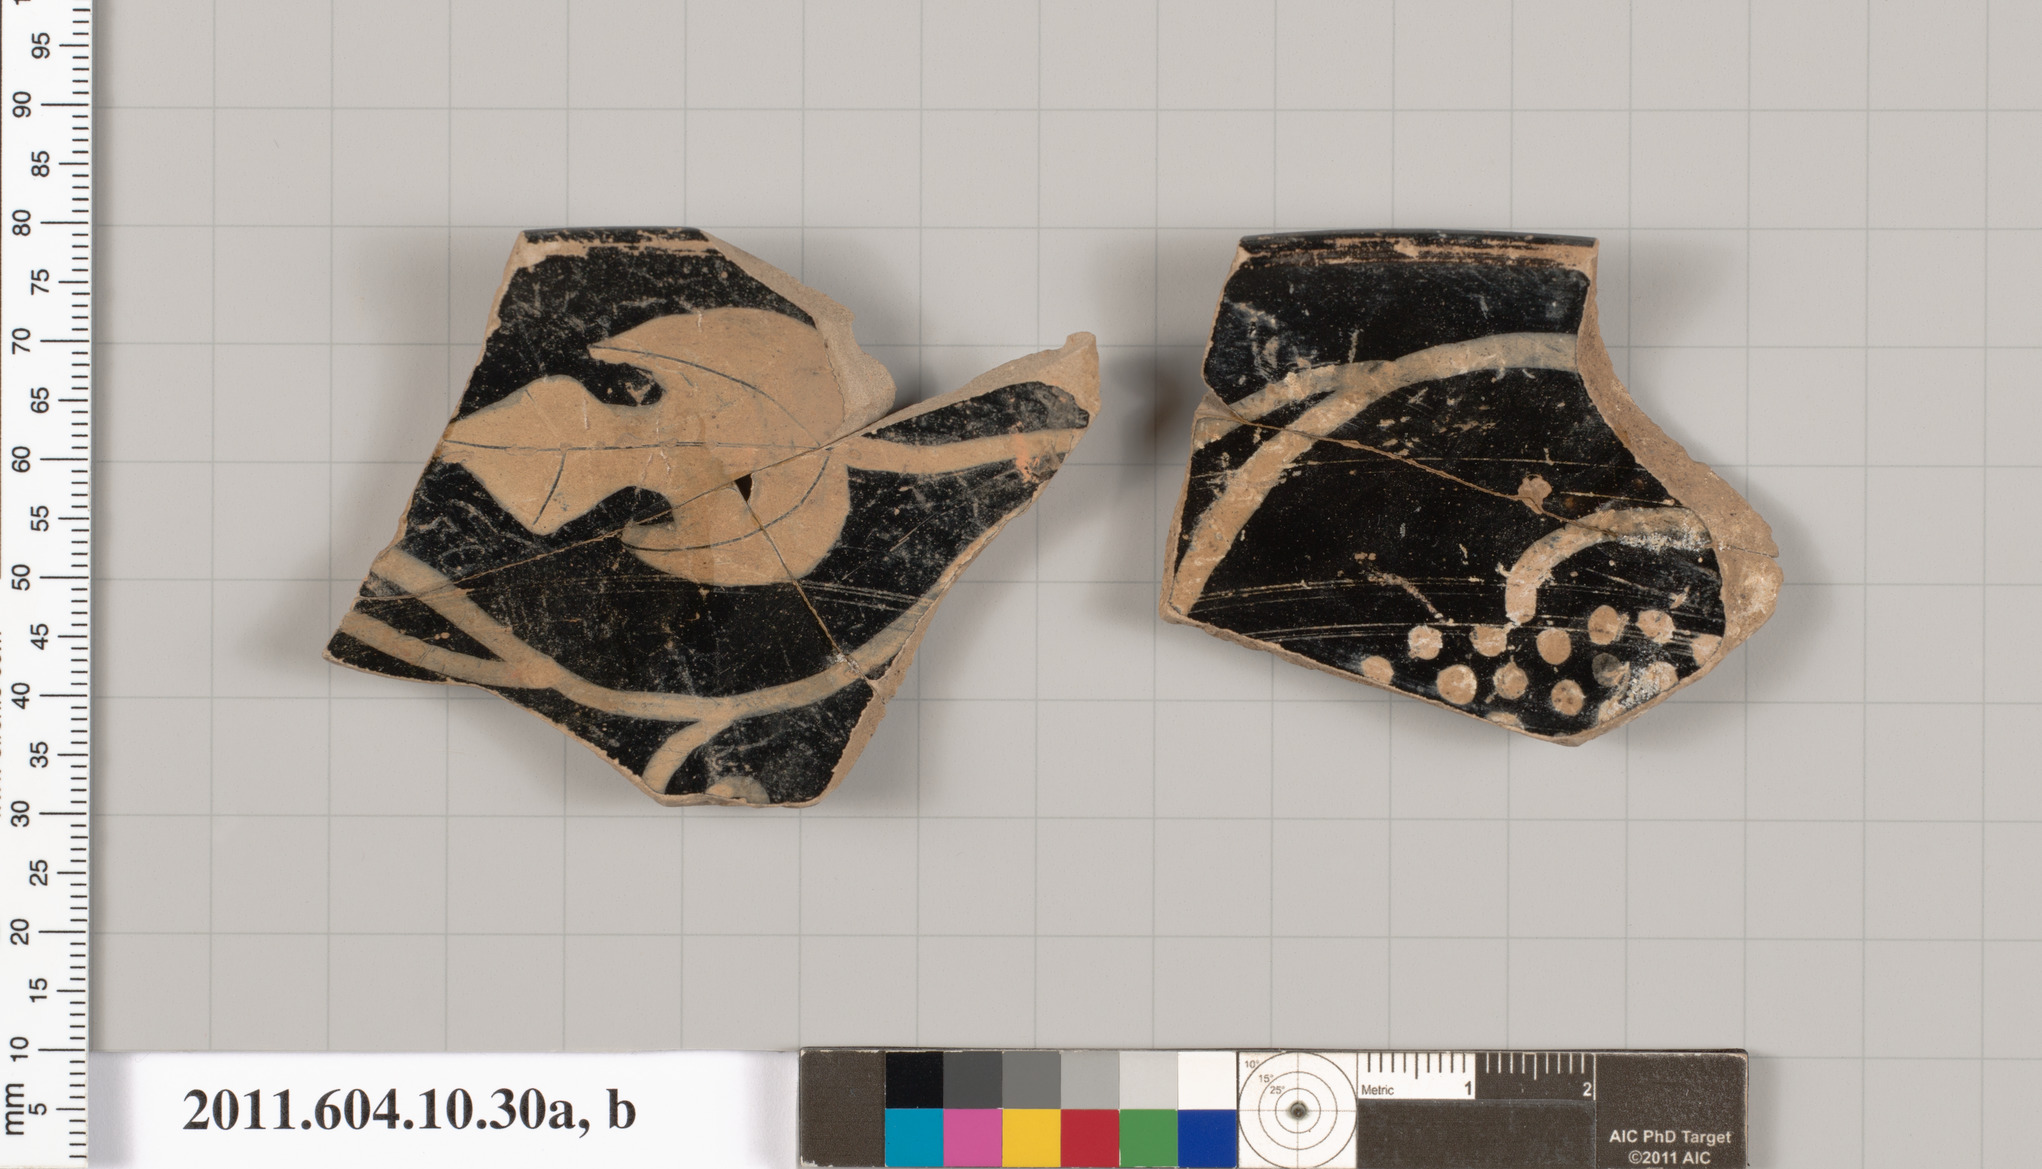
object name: kylix fragment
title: Terracotta rim fragments of a kylix (drinking cup)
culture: etruscan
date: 434-368 BCE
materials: terracotta